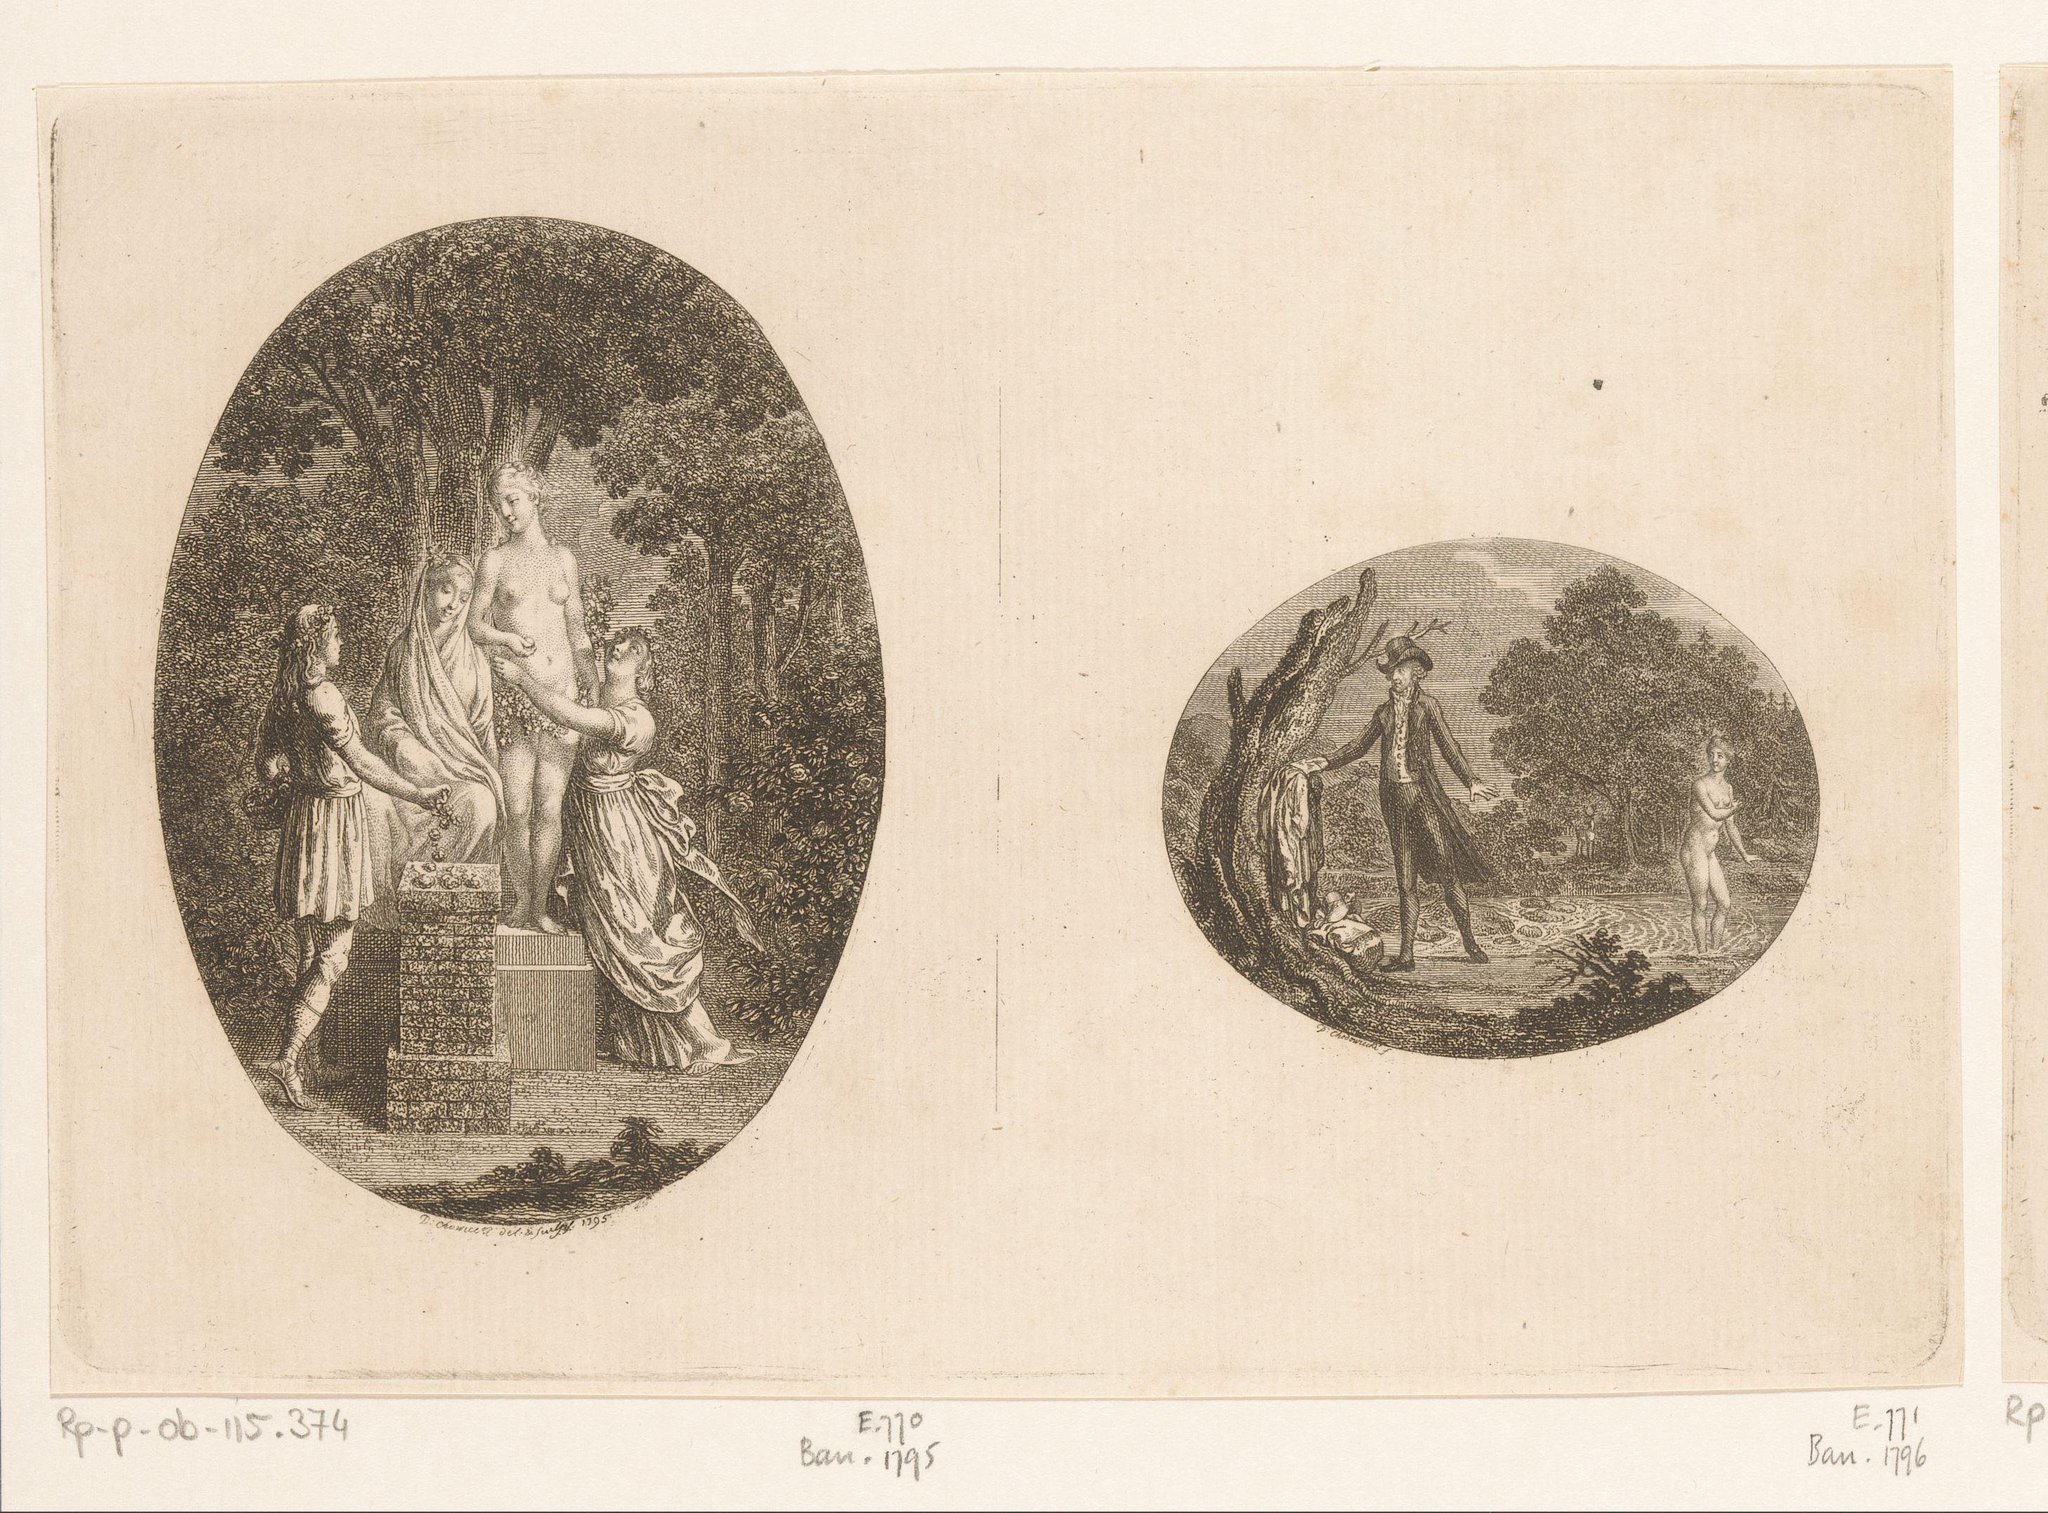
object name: print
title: Twee voorstellingen uit Feyer der Liebe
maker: daniel nikolaus chodowiecki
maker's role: draughtsman, print maker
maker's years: 1726-1801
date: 1795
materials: paper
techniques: etching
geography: berlin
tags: offering; 'offerta overo oblatione' (ripa), garland, wreath, graces (charites), generally three in number; 'gratie' (ripa), monument, statue, (story of) venus (aphrodite), taking a bath - aa - in the open air, letter, envelope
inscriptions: collector's mark: Lugt 2228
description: Links: de verering van de beelden van Venus en een gratie. Rechts: de heer legt een brief bij de kleding van de badende dame.